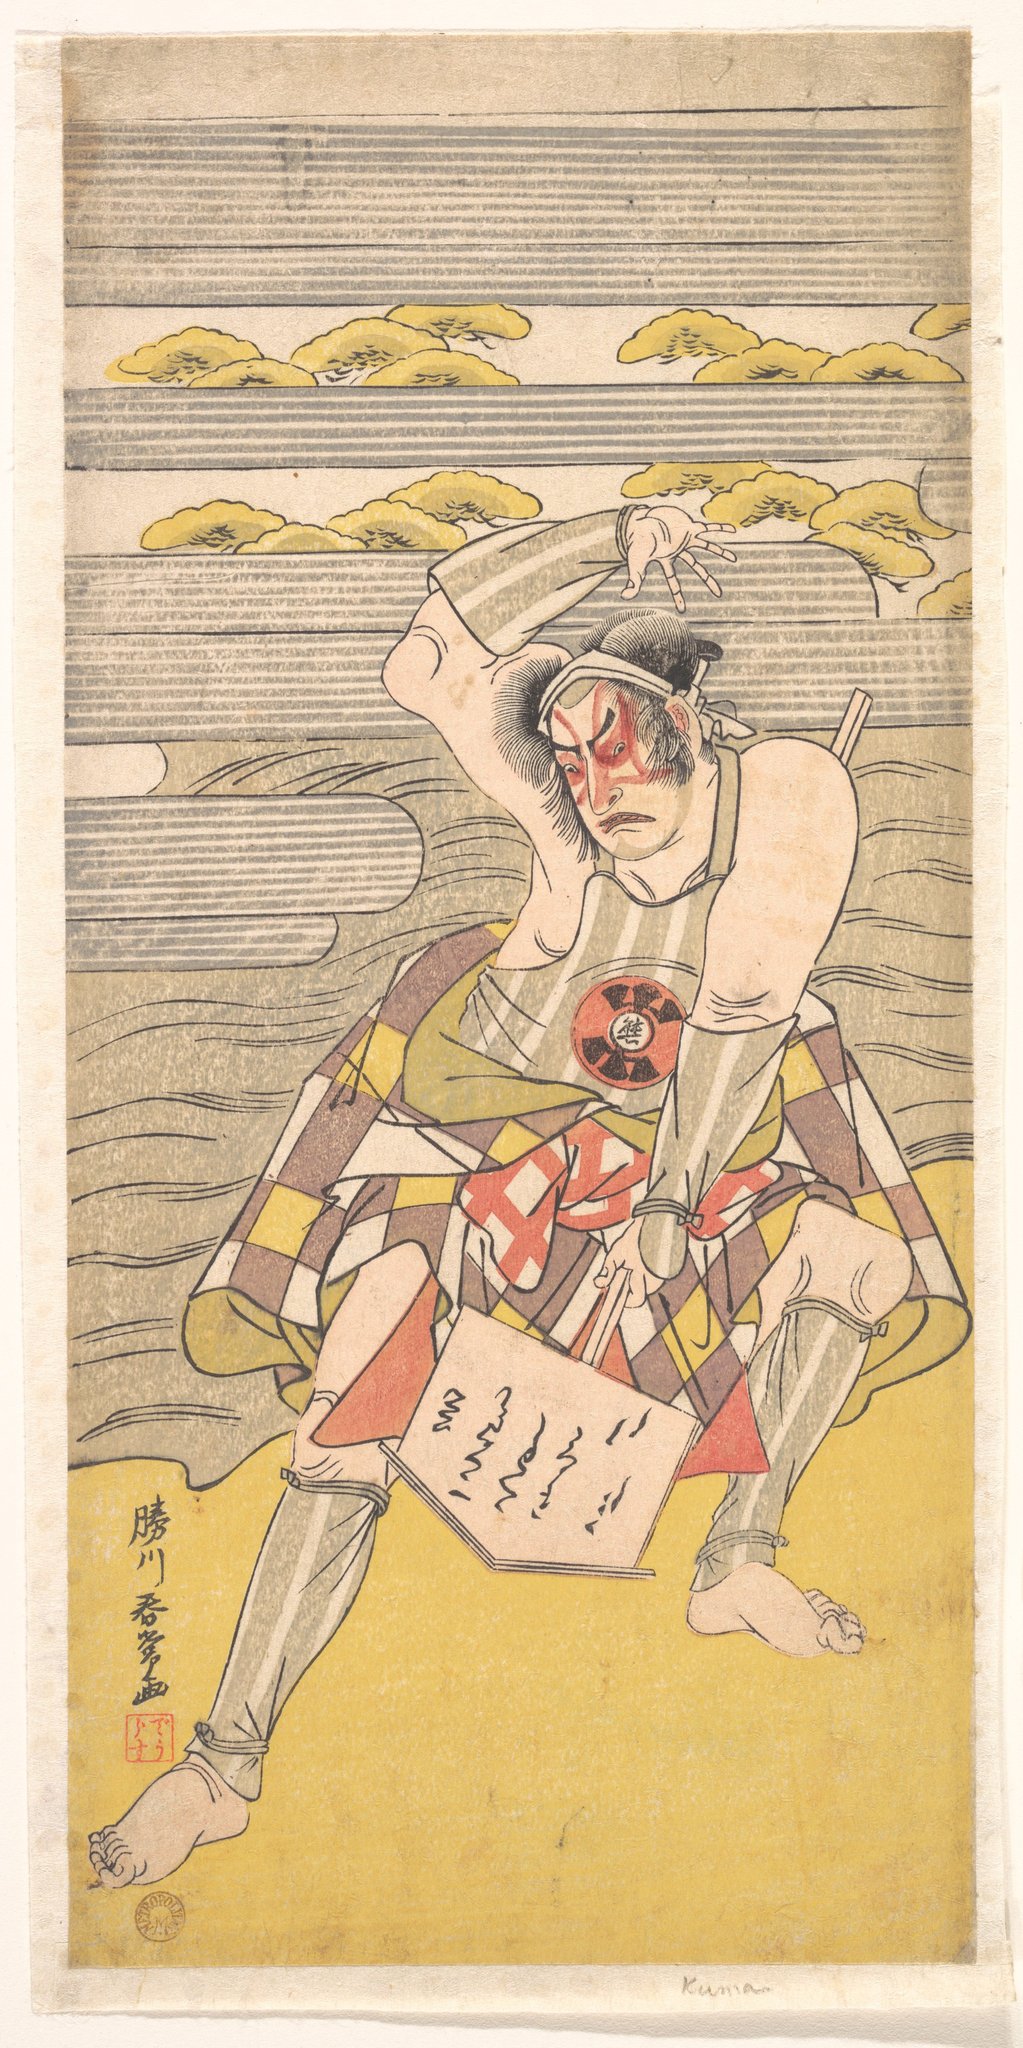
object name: print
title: An Actor of the Bando Line as an Outlaw Brought to Bay on the Bank of a River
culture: japanese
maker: katsukawa shunjō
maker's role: artist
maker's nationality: japanese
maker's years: 1700-1787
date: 1780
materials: ink, paper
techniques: woodblock print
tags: men,actors